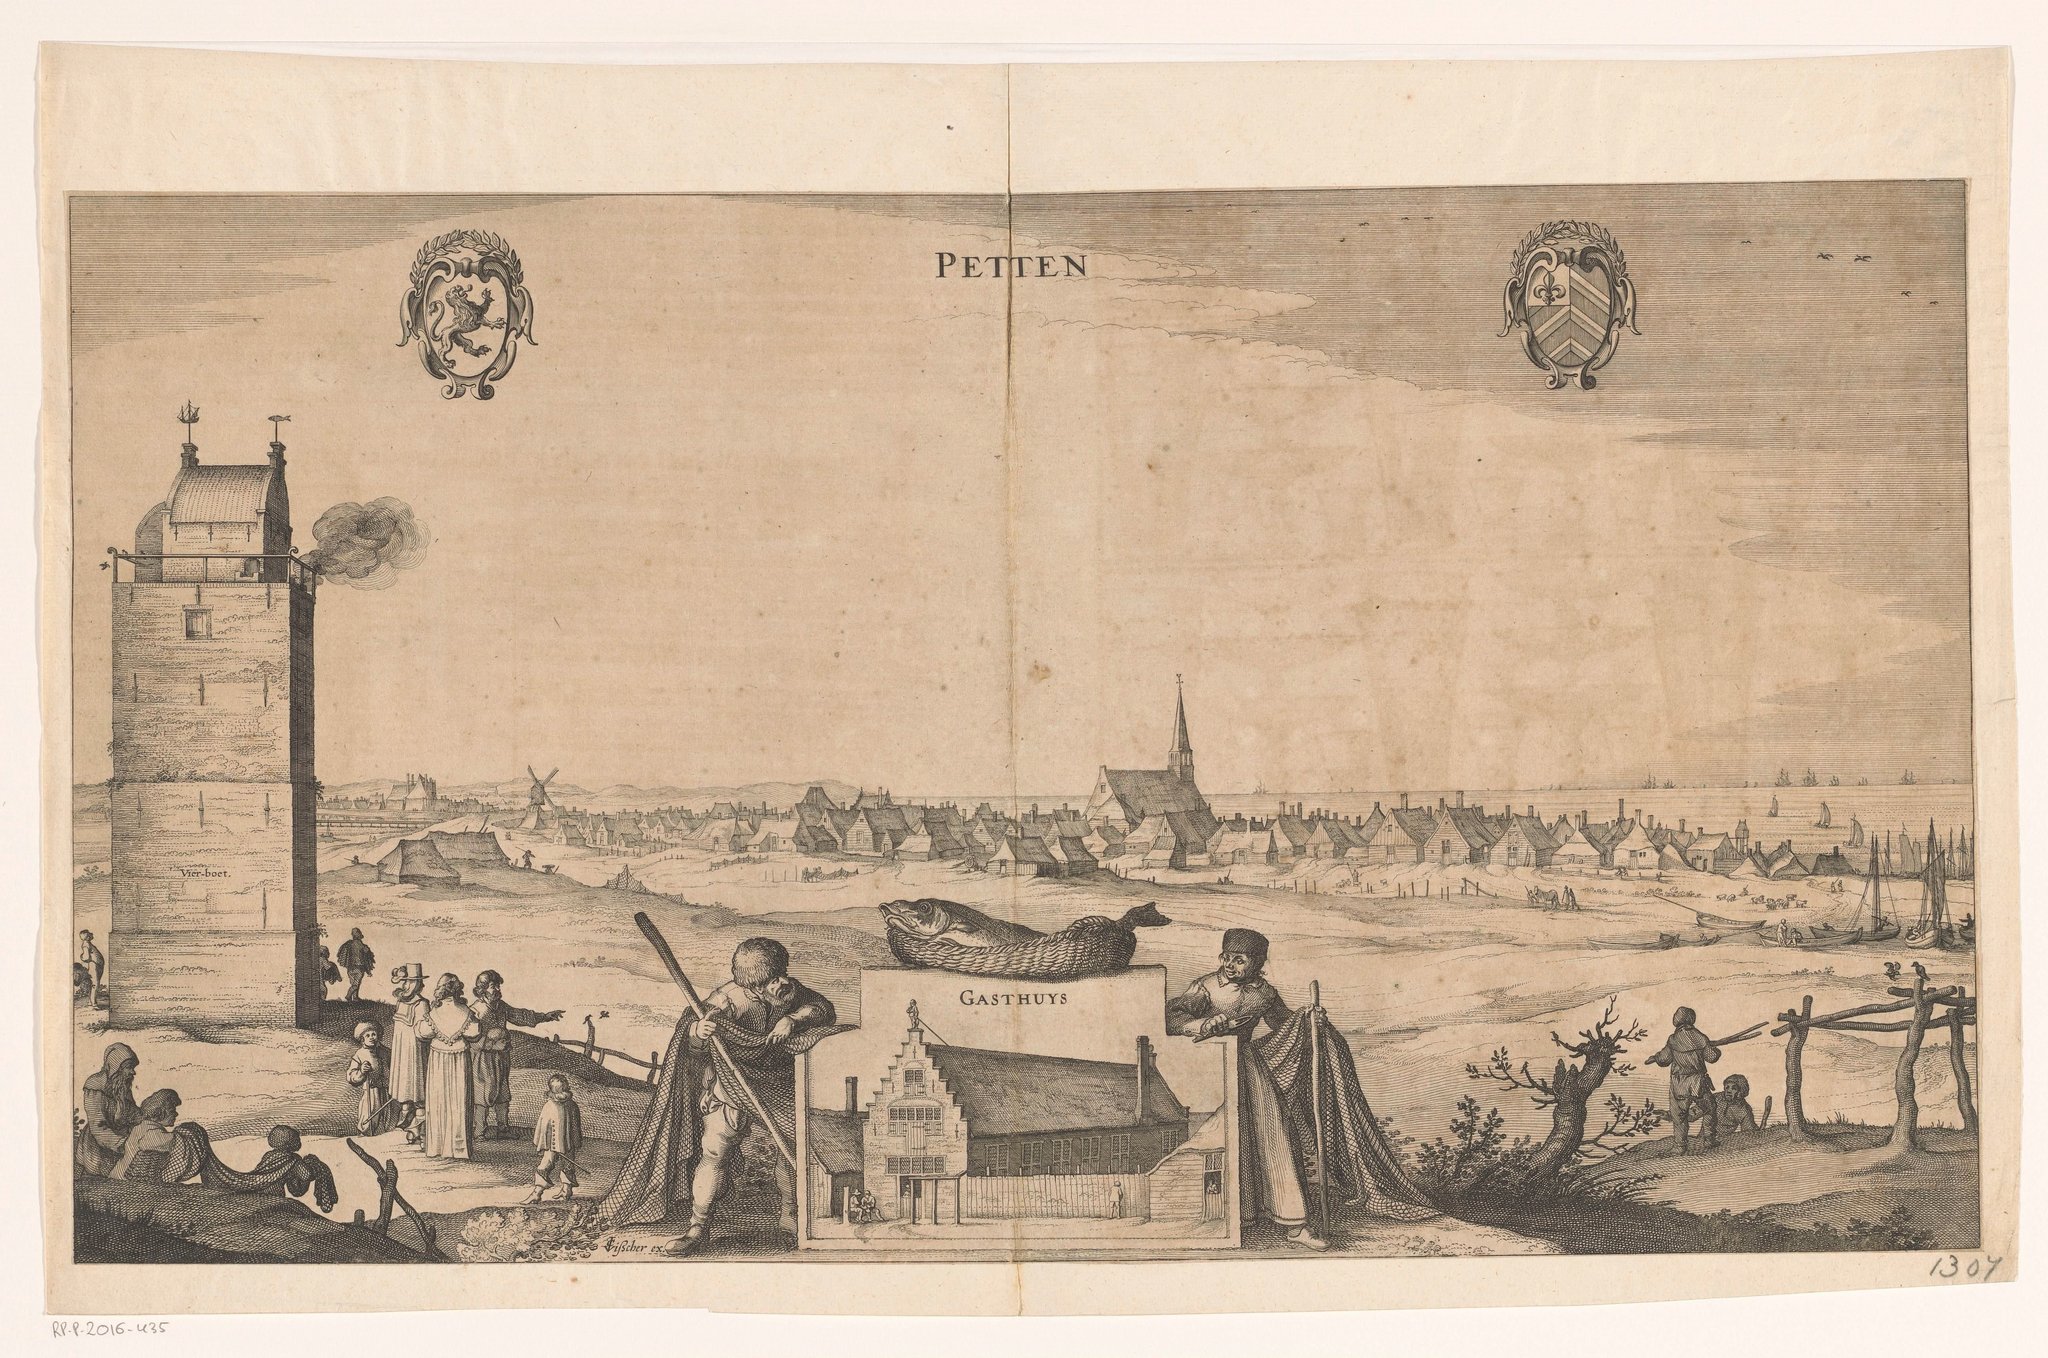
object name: loterijprent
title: Petten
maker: claes jansz. visscher (ii)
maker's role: draughtsman, print maker, publisher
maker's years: 1586-1652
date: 1643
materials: paper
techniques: engraving, etching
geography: amsterdam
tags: raffle, lottery, sailing-ship, sailing-boat, urination, fisherman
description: De loterij te Petten ten behoeve van een nieuw gasthuis, 1643. Op de voorgrond twee vissers (man en vrouw) bij een opstaande plaat met een afbeelding van het nieuwe gasthuis. Op de plaat een mand met een vis, links een vuurtoren met enkele vissers en wandelaars. Op de achtergrond het dorp aan de kust. Bovenaan de naam van het dorp met aan weerszijden de wapens van Holland en van Petten.